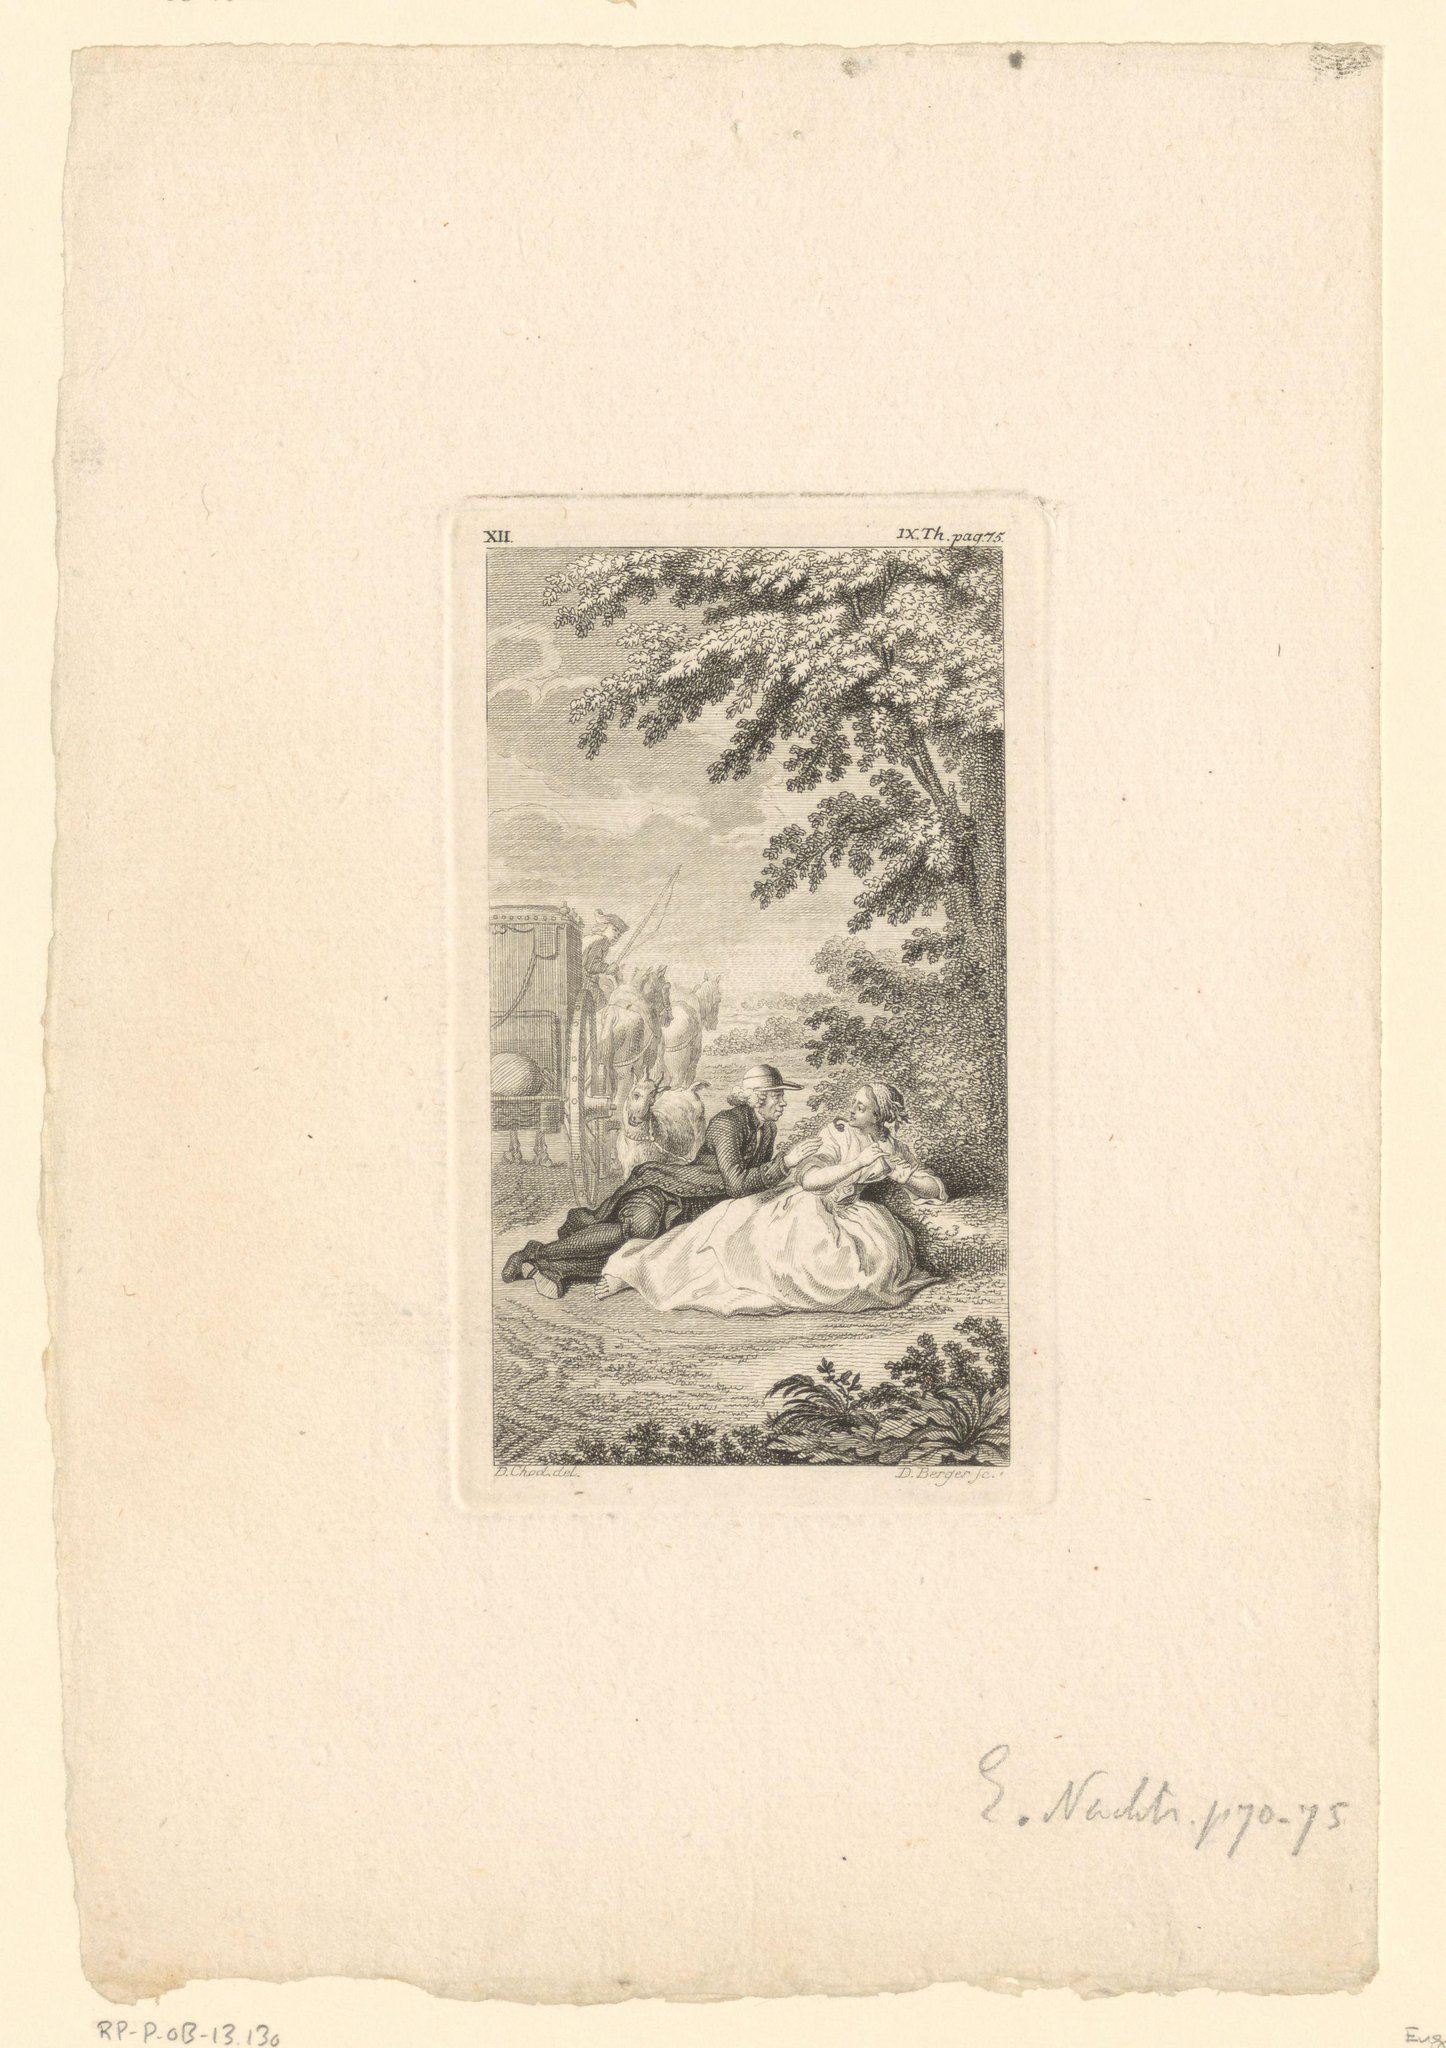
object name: print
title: Tristram Shandy en Maria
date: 1778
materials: paper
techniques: etching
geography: berlin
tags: london, clergyman, four-wheeled, animal-drawn vehicle, e.g.: cab, carriage, coach, literary characters and objects, goat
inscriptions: collector's mark: Lugt 240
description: Twaalfde prent uit de serie 'XII Kupfer zu den Leben und Meynungen Tristram Shandy's' gedrukt op kosten van de Berlijnse boekhandelaar Christian Friedrich Himburg in 1778. De illustraties volgen een eerder verschenen tekstuitgave: [Stern, Laurence]. Tristram Schandis Leben und Meynungen [uit het Duits vertaald door] Johann Joachim Christoph Bode. 9 dln. Hamburg: Carl Ernst Bohn te Hamburg, 1776.